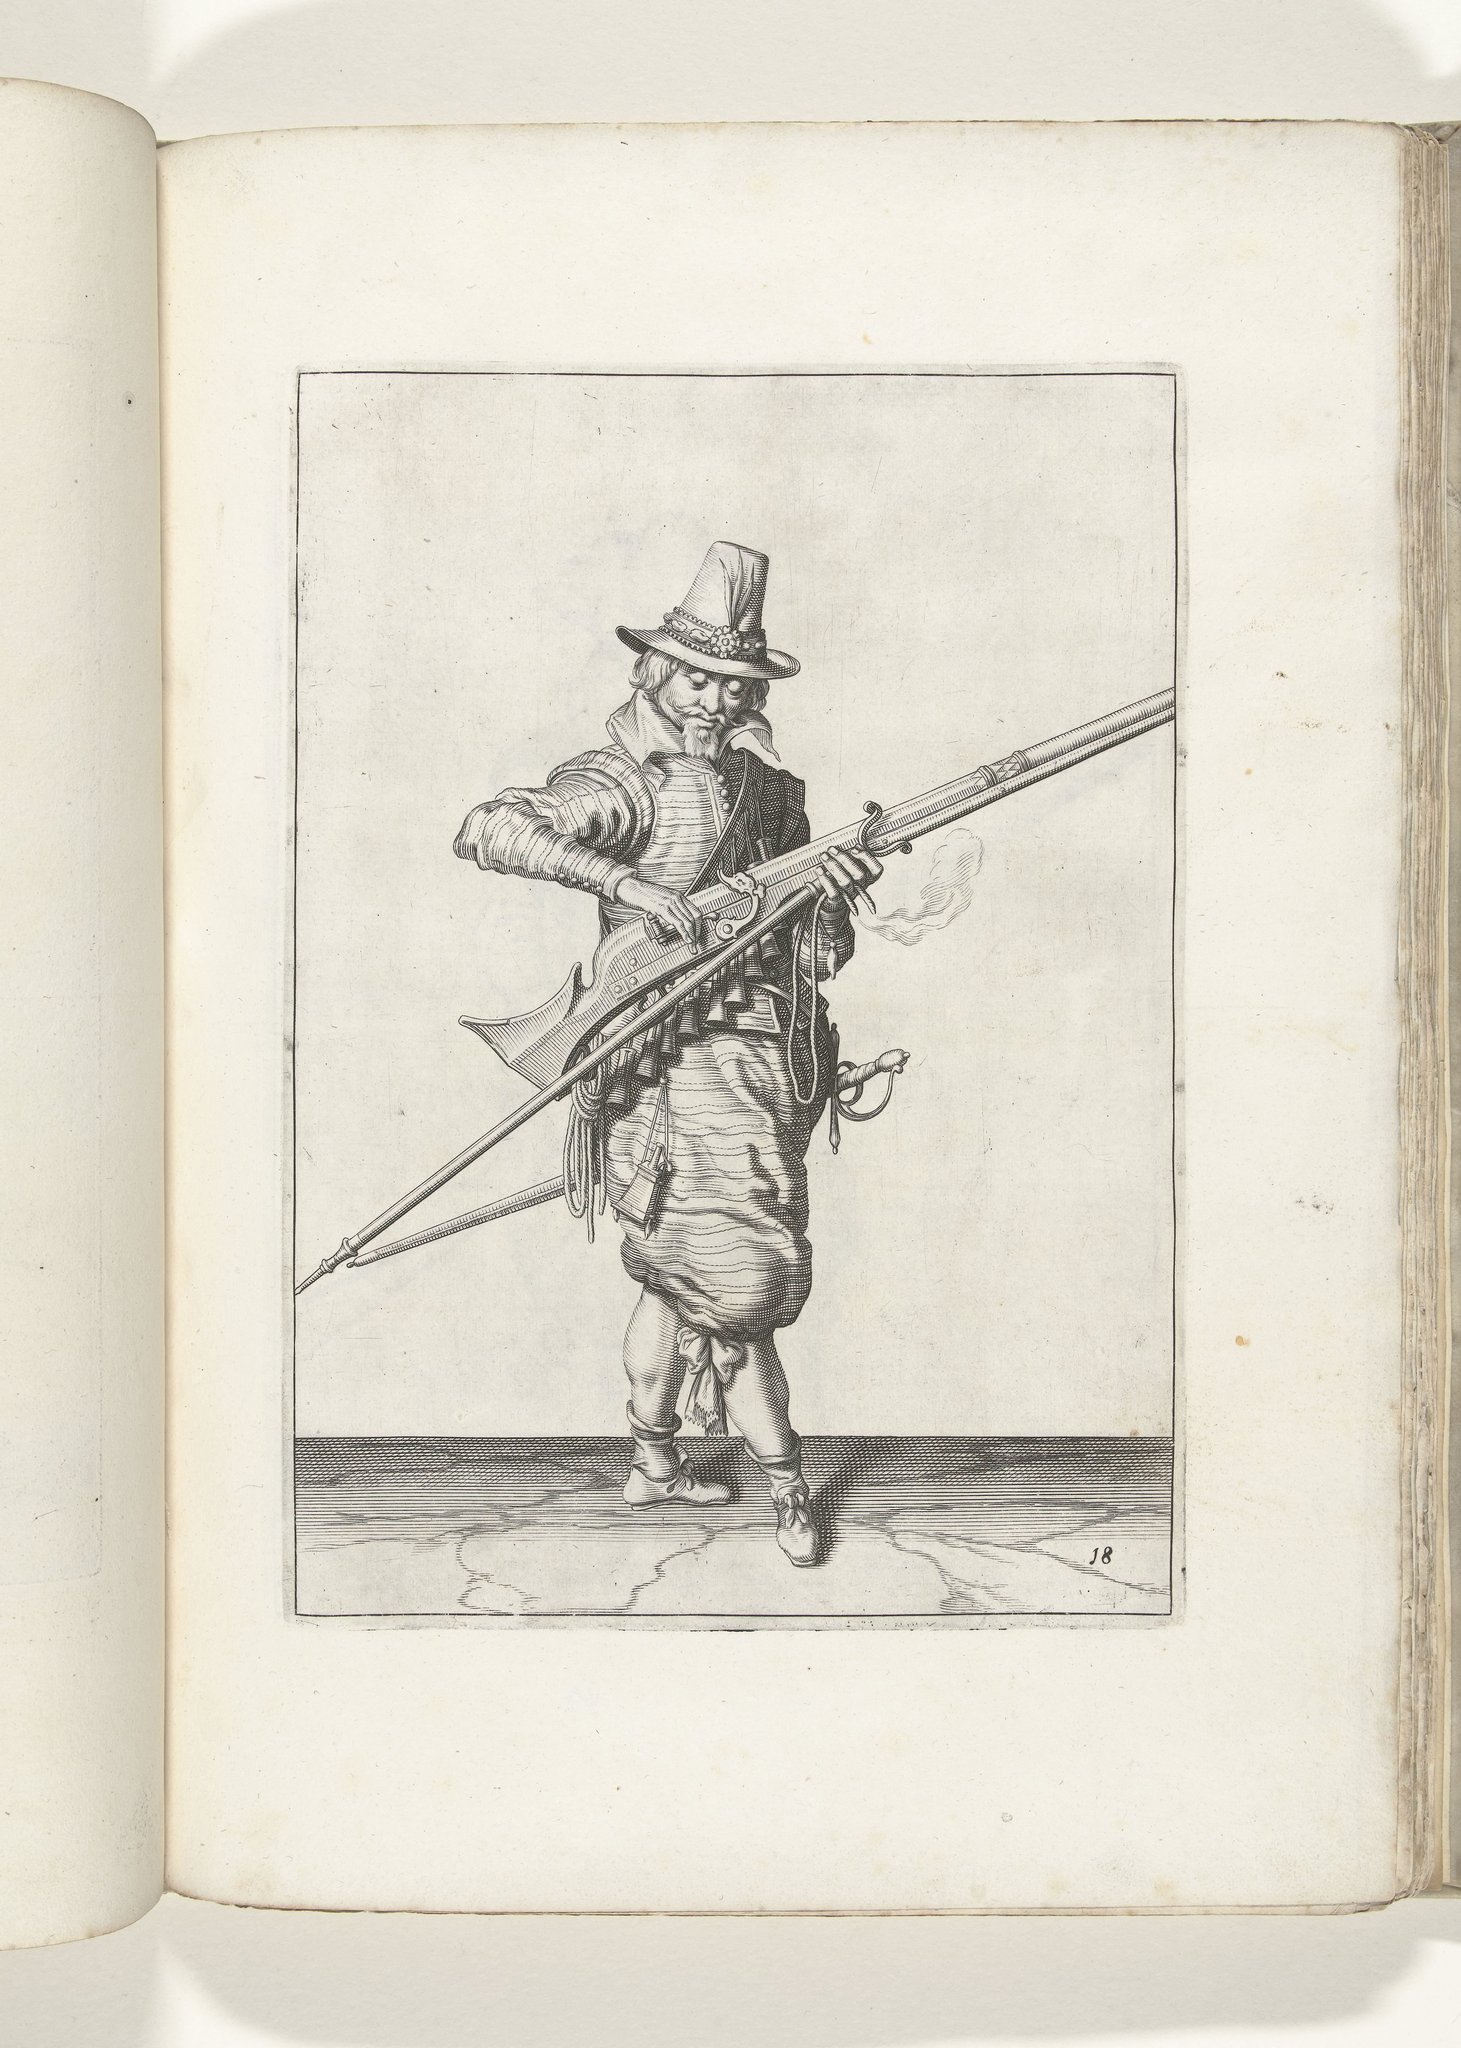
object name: print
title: Soldaat die de pan van zijn musket sluit (nr. 18), ca. 1600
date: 1597-1607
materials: paper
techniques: engraving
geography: northern netherlands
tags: maurice (prince of orange), handling of weapons ~ military training, weapons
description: Een soldaat, ten voeten uit, naar rechts, die met zijn rechterhand de pan (het kruitreservoir) van zijn musket (een bepaald type vuurwapen) sluit (nr. 18), ca. 1600. In zijn linkerhand behalve het musket ook een furket (musketvork) en een brandende lont. Plaat 18 in de instructies voor het hanteren van het musket: Corte onderrechtinghe op de figuerliicke afbeeldinghe, soo veel aengaet het recht ghebruyck vant Musquet. Onderdeel van de illustraties in: J. de Gheyn, Wapenhandelinghe van Roers Musquetten ende spiessen, 's-Gravenhage, 1607. Krijgswezen rond 1600.